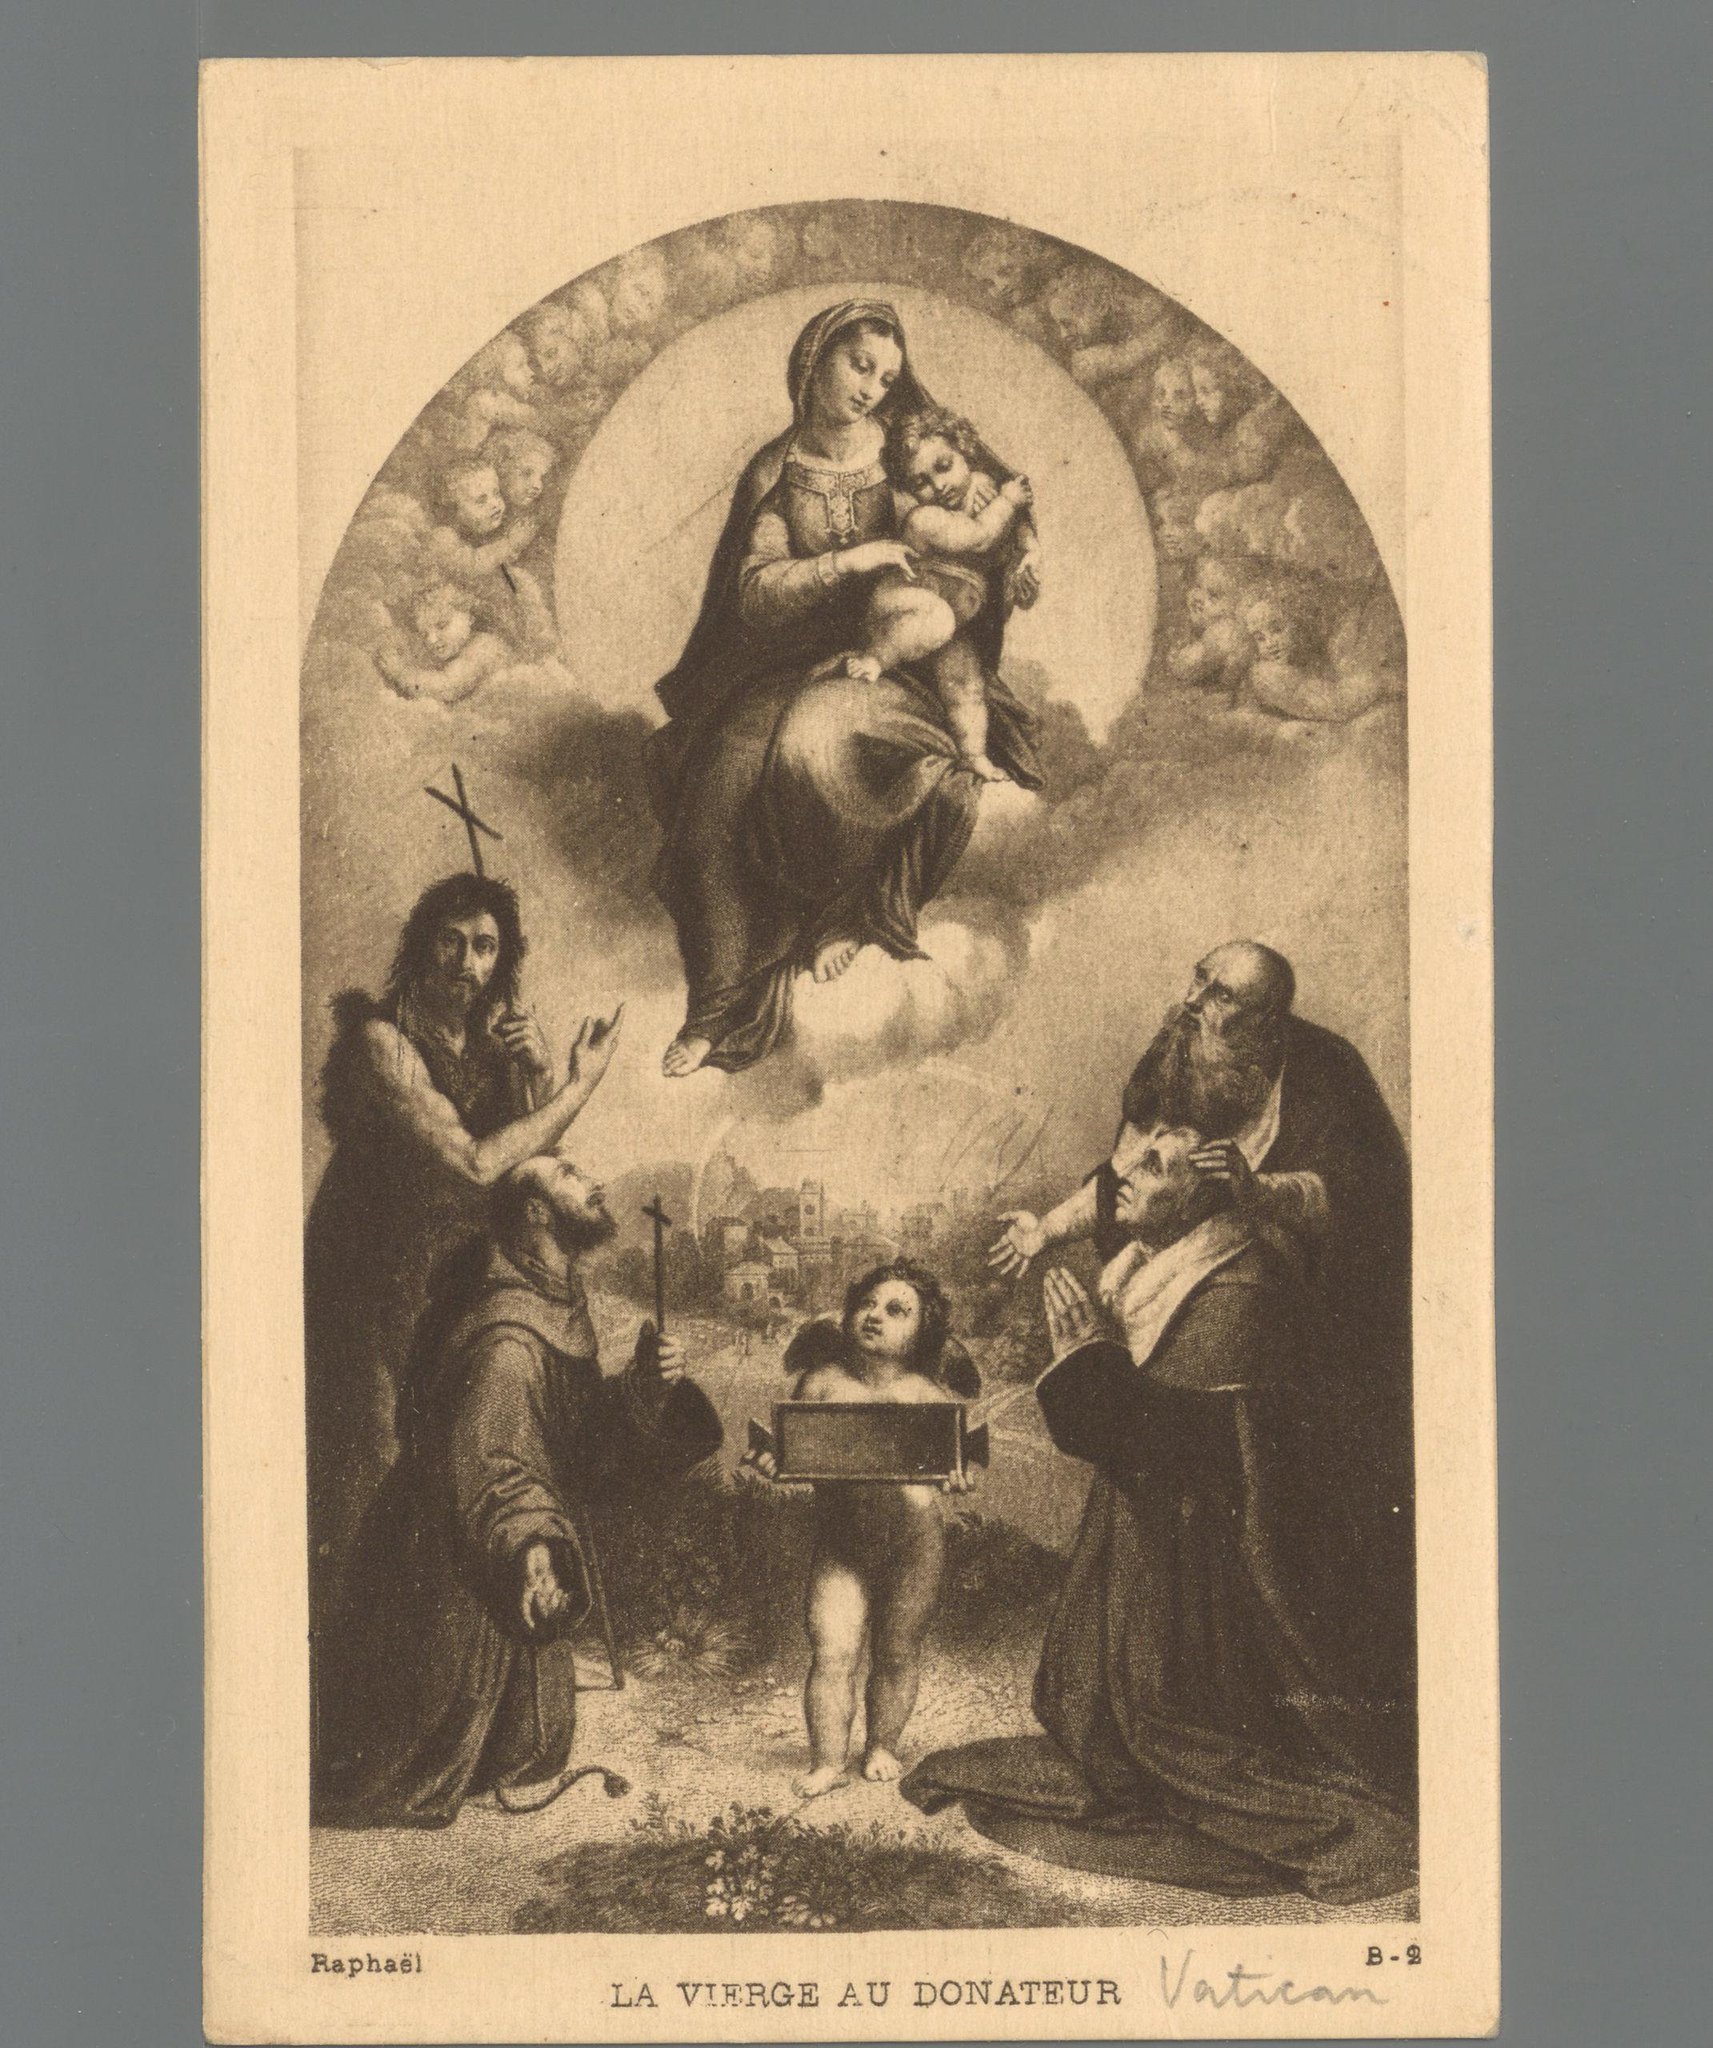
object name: photomechanical print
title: La Vierge au Donateur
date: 1903-1929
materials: cardboard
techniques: rotogravure, writing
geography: paris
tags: series of scenes from the life of mary, permanent exhibition, museum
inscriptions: postage stamp, collector's mark: ‘AFE v S’